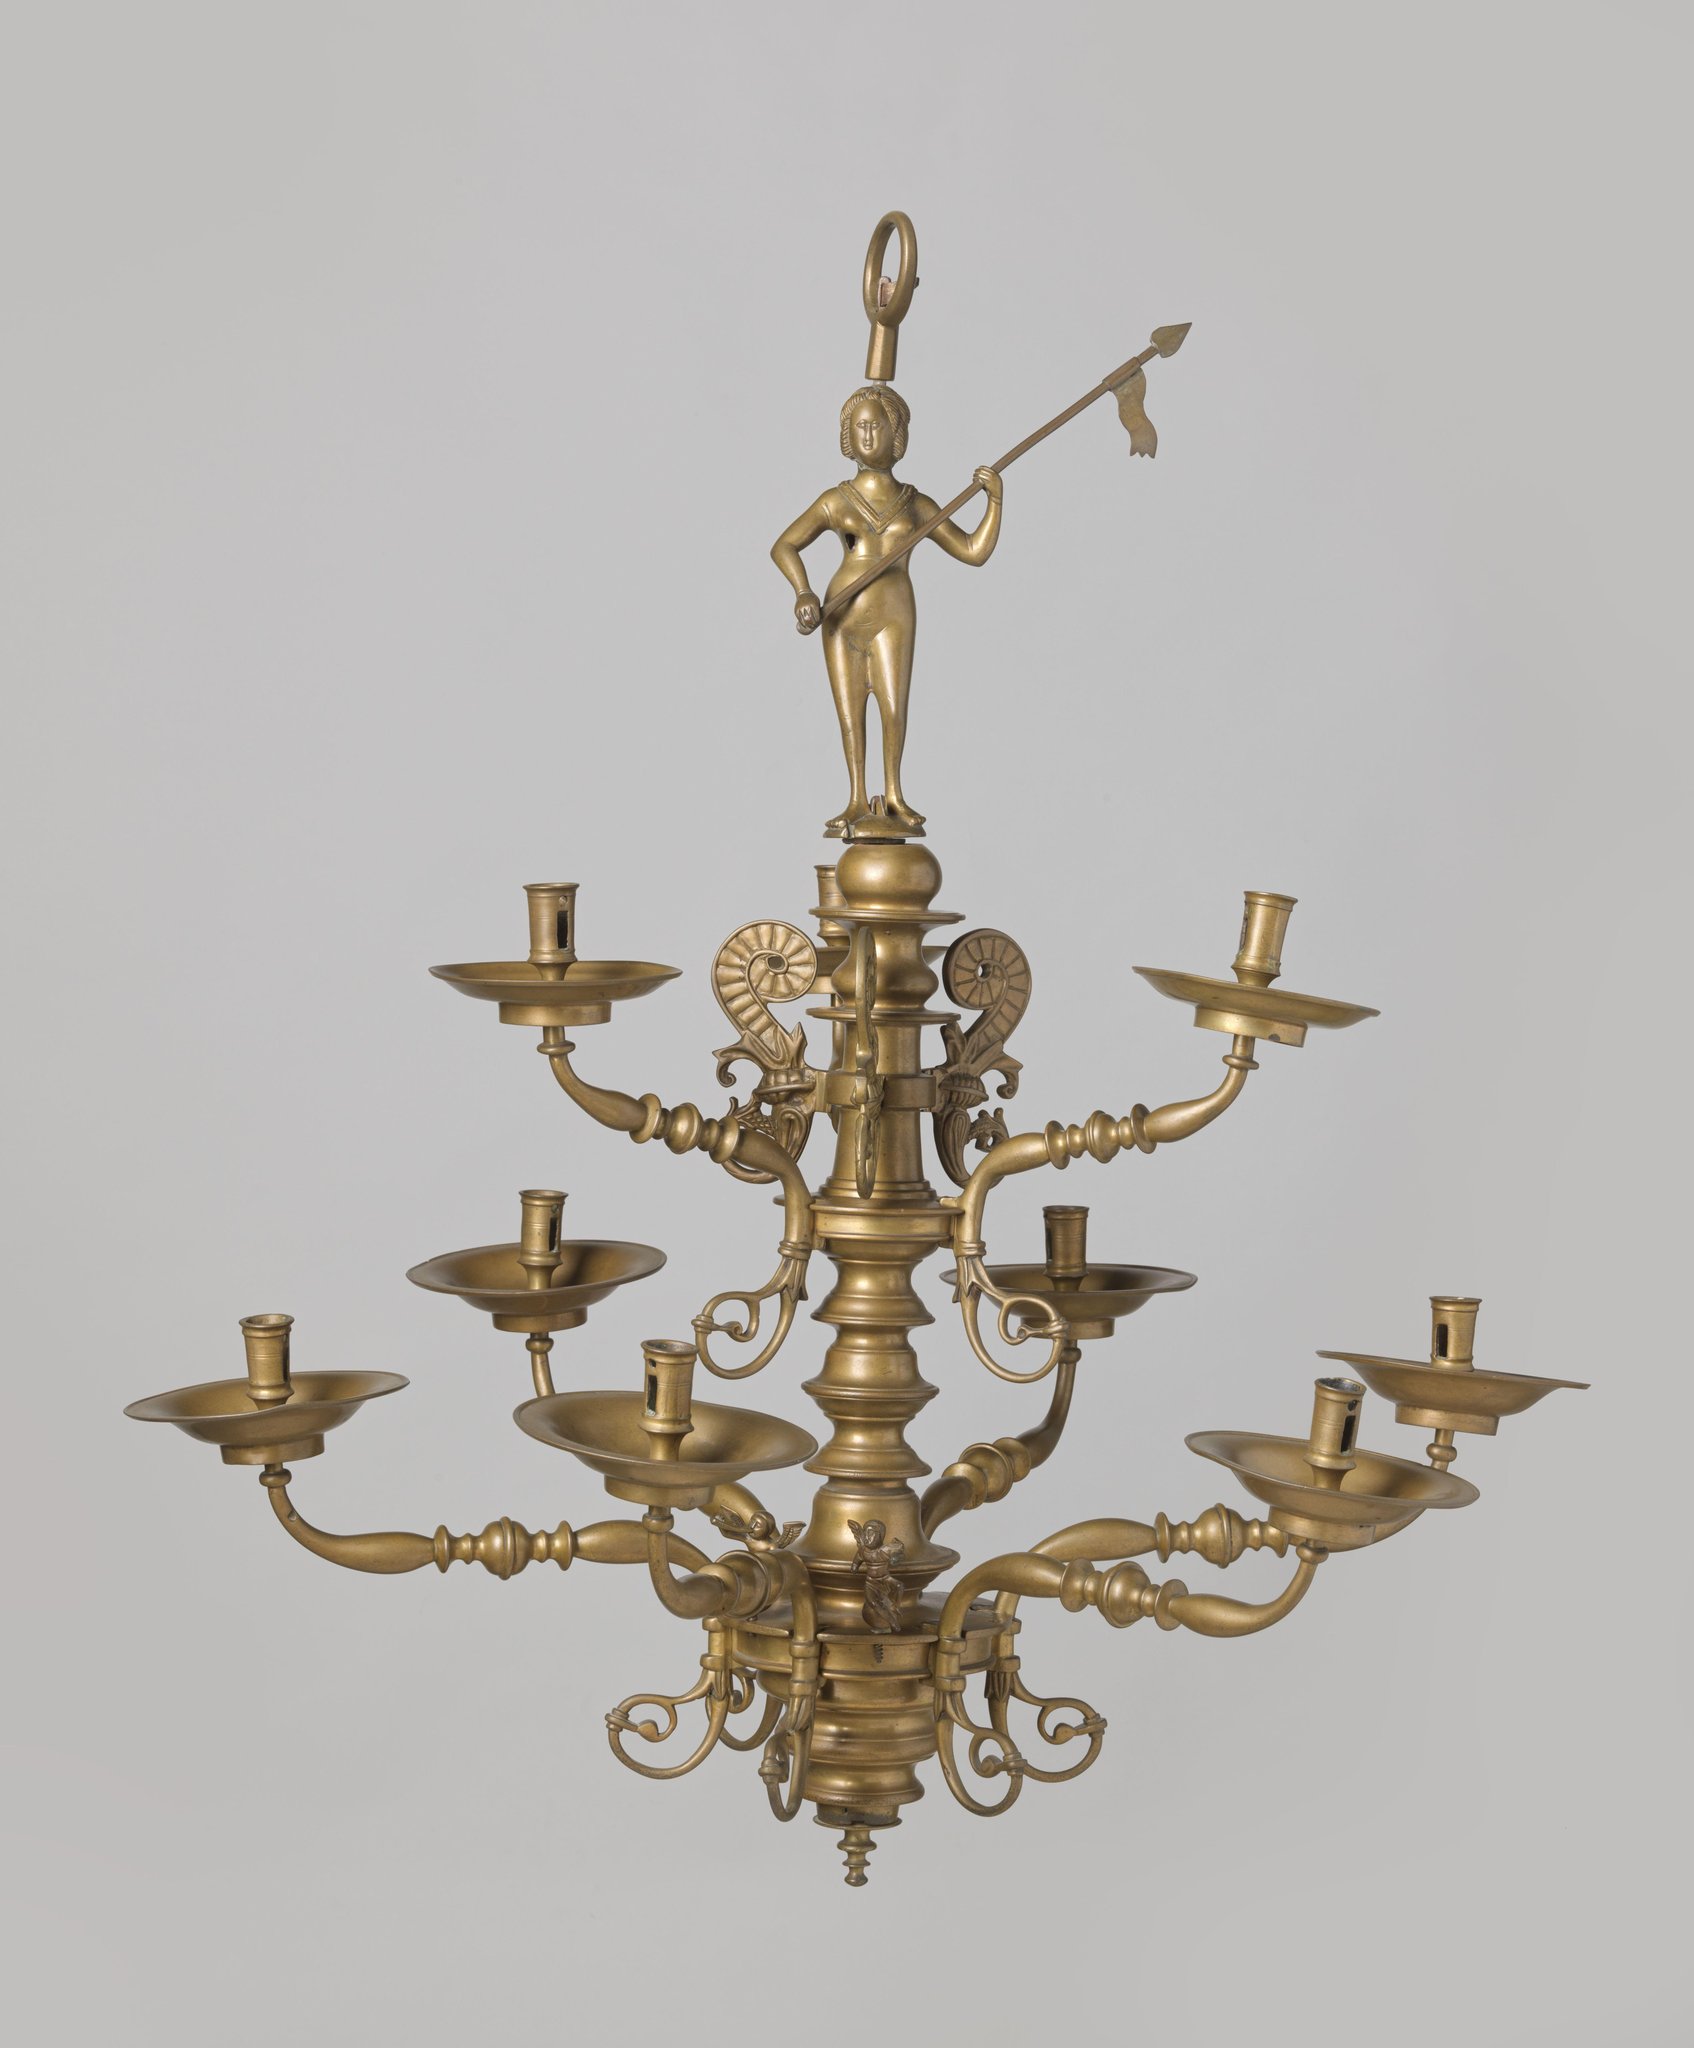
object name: chandelier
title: Arm met kaarsenhouder van kaarsenkroon van twee hoogten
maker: Anonymous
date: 1525-1575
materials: brass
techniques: casting, screwed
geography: north germany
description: Kaarsenarm behorende bij een kaarsenkroon van twee hoogten met naakte vrouw bovenaan. De arm heeft in het midden een bol- en holrond geprofileerde nodus en verdikt zich een weinig aan weerszijden. Bij de stam loopt zij uit in een spiraalvormige krul. Naar buiten toe mondt zij uit in het schroefeind van ijzer. Daarop bevindt zich de ronde vetvanger met onderaan een afstaande rand. De ronde in elkaars verlengde opengewerkte kaarsenhouder heeft een holronde voet, die op de arm is geschroefd. Dit is de eerste arm van de onderste ring, genummerd met 1 ruitvormige punt. De kaarsenhouder is ongenummerd.